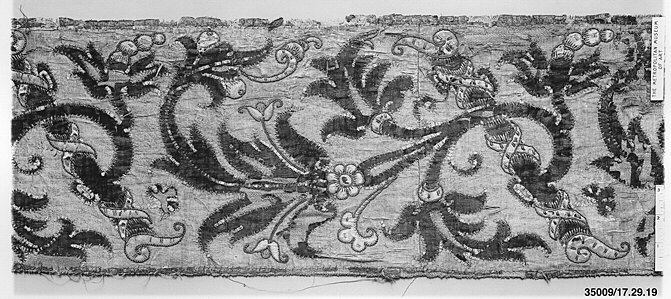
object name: strip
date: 1601-1700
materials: velvet